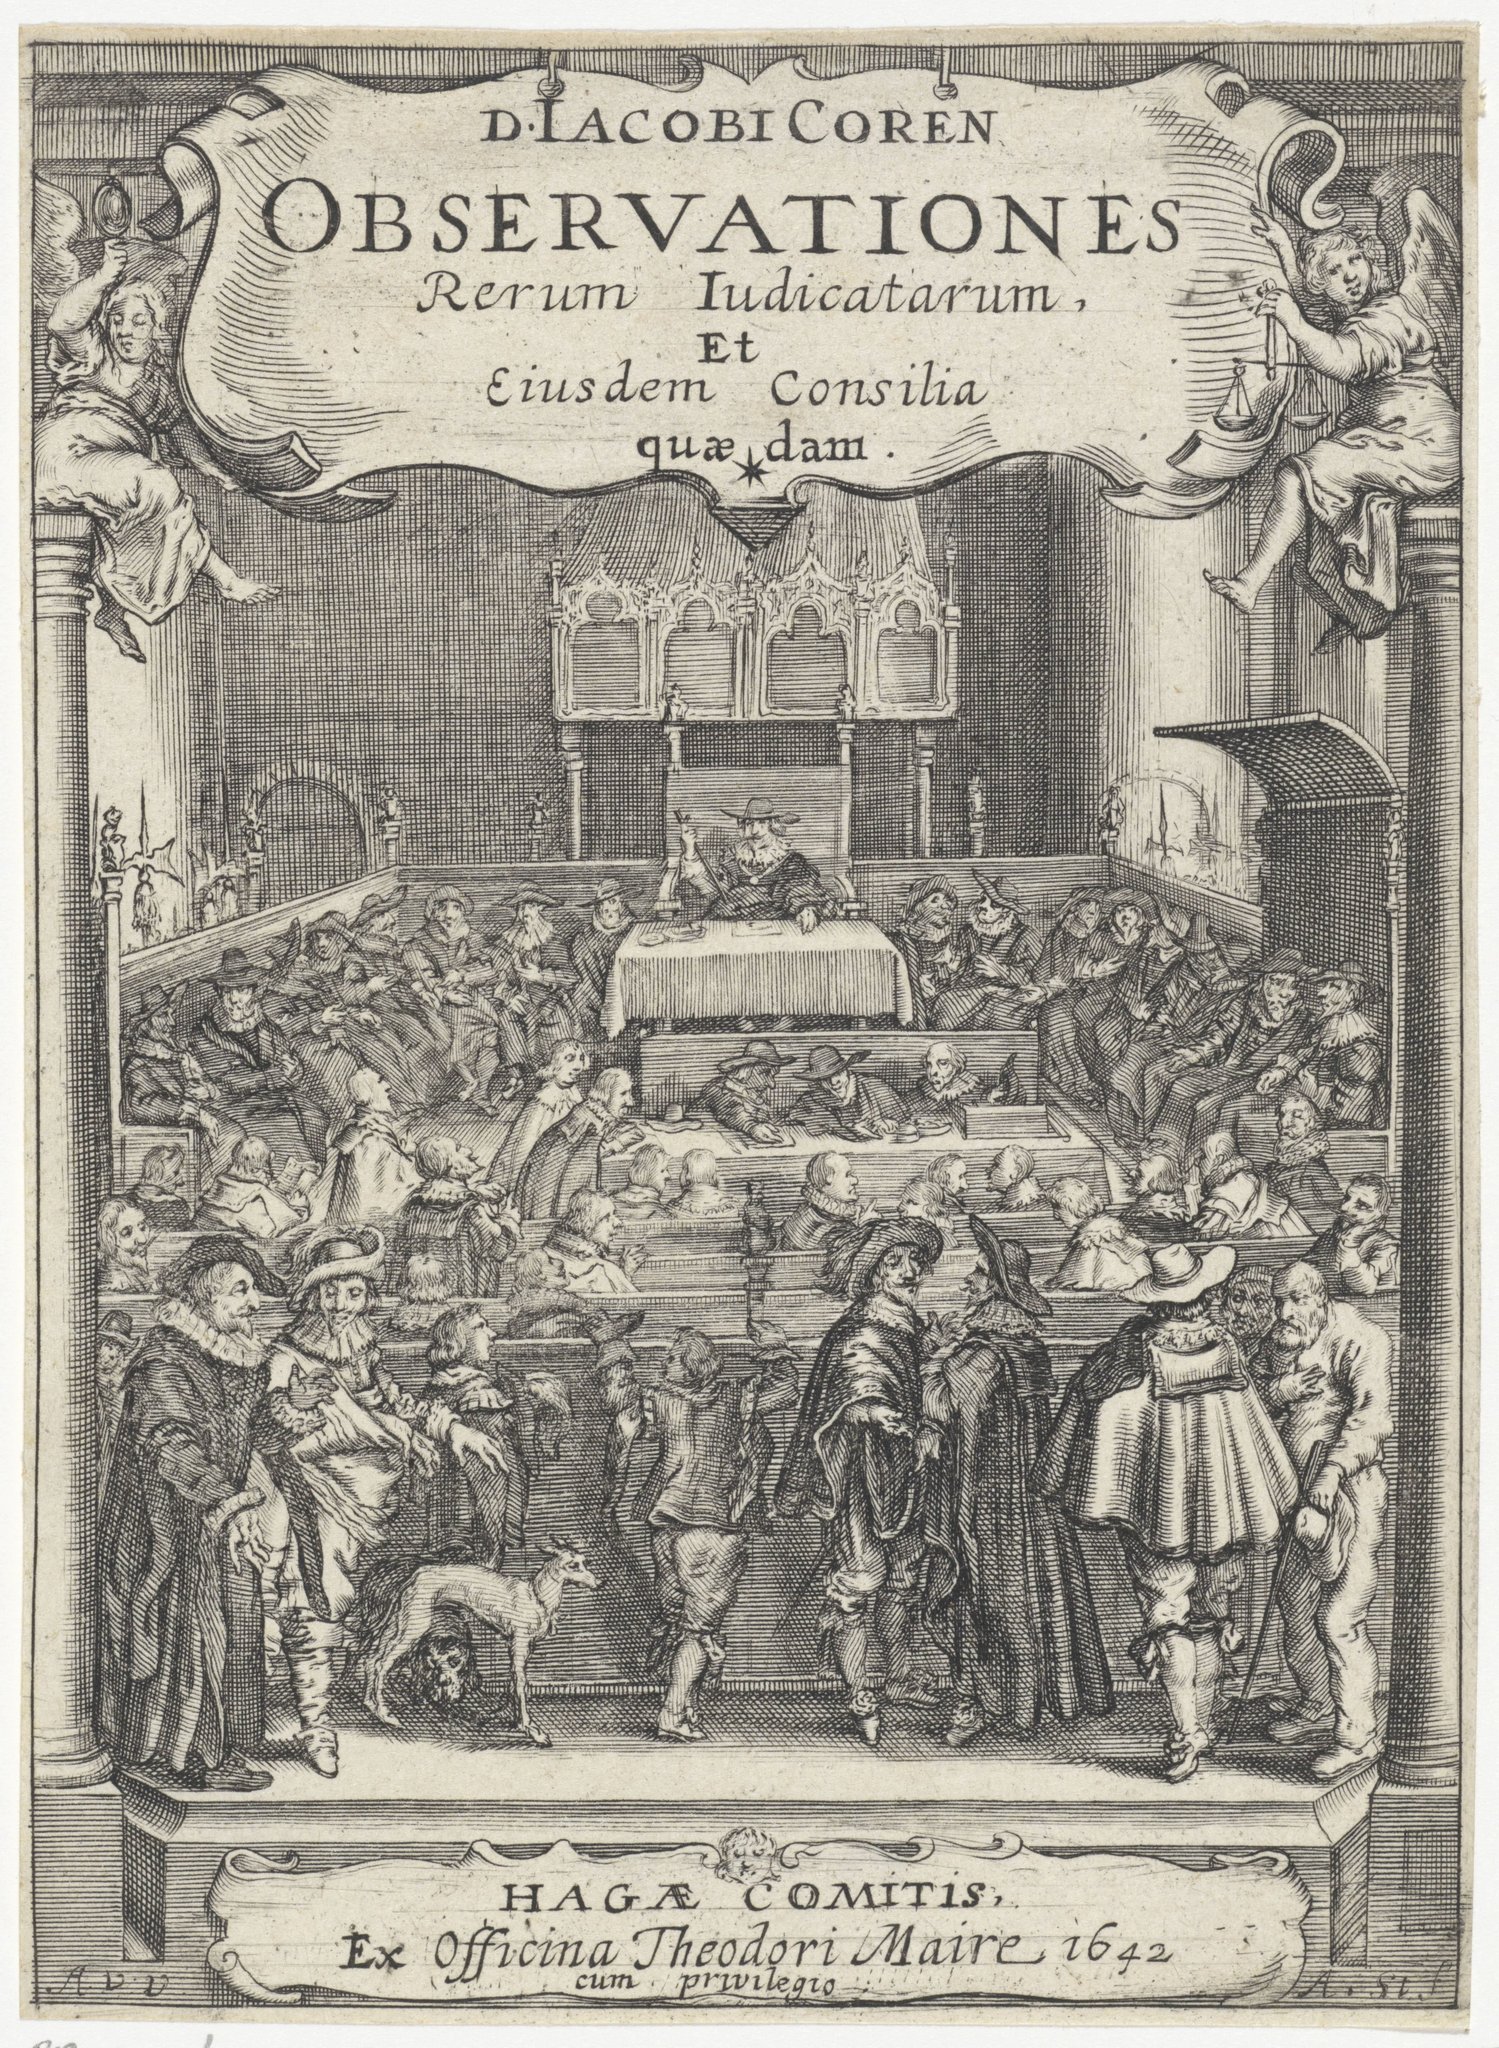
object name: print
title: Titelpagina voor: Jacobus Gerardus Coorn, Observationes, 1642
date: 1633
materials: paper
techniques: engraving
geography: the hague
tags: court-room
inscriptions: collector's mark: Lugt 2228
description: Interieur van een rechtszaal met Jacob Gerritsz. Coren als rechtsgeleerde en raadsheer in het midden onder een baldakijn.